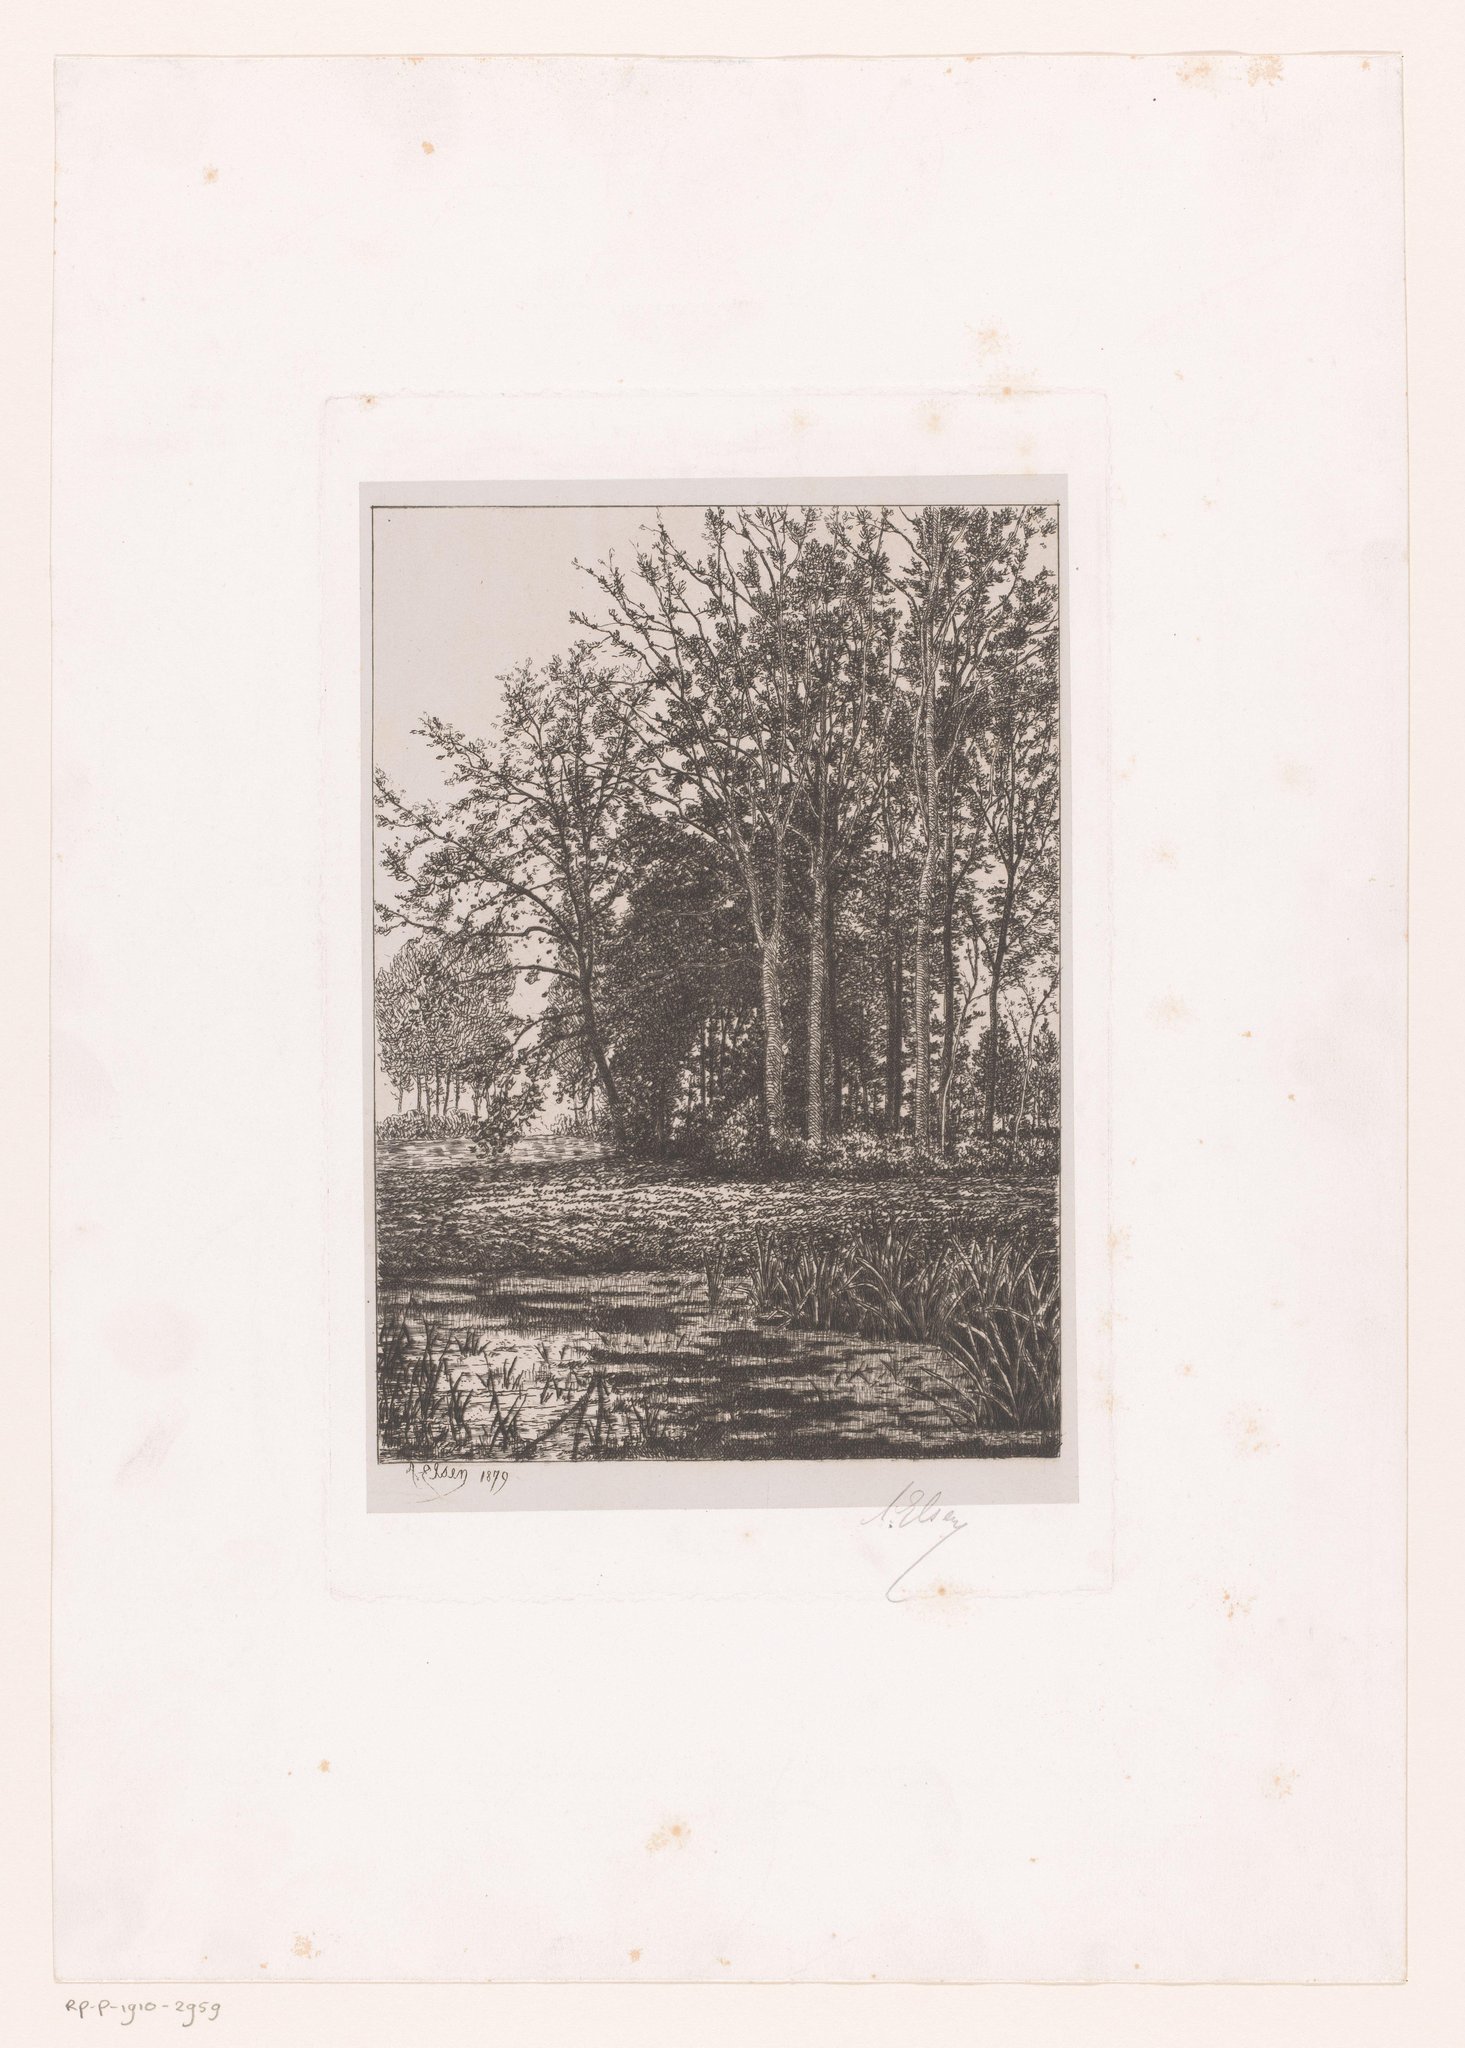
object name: print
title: Landschap met water en bomen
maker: alfred elsen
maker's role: painter, print maker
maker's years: 1850-1914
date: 1879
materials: paper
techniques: etching, intaglio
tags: trees, lake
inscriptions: collector's mark: Lugt 2228